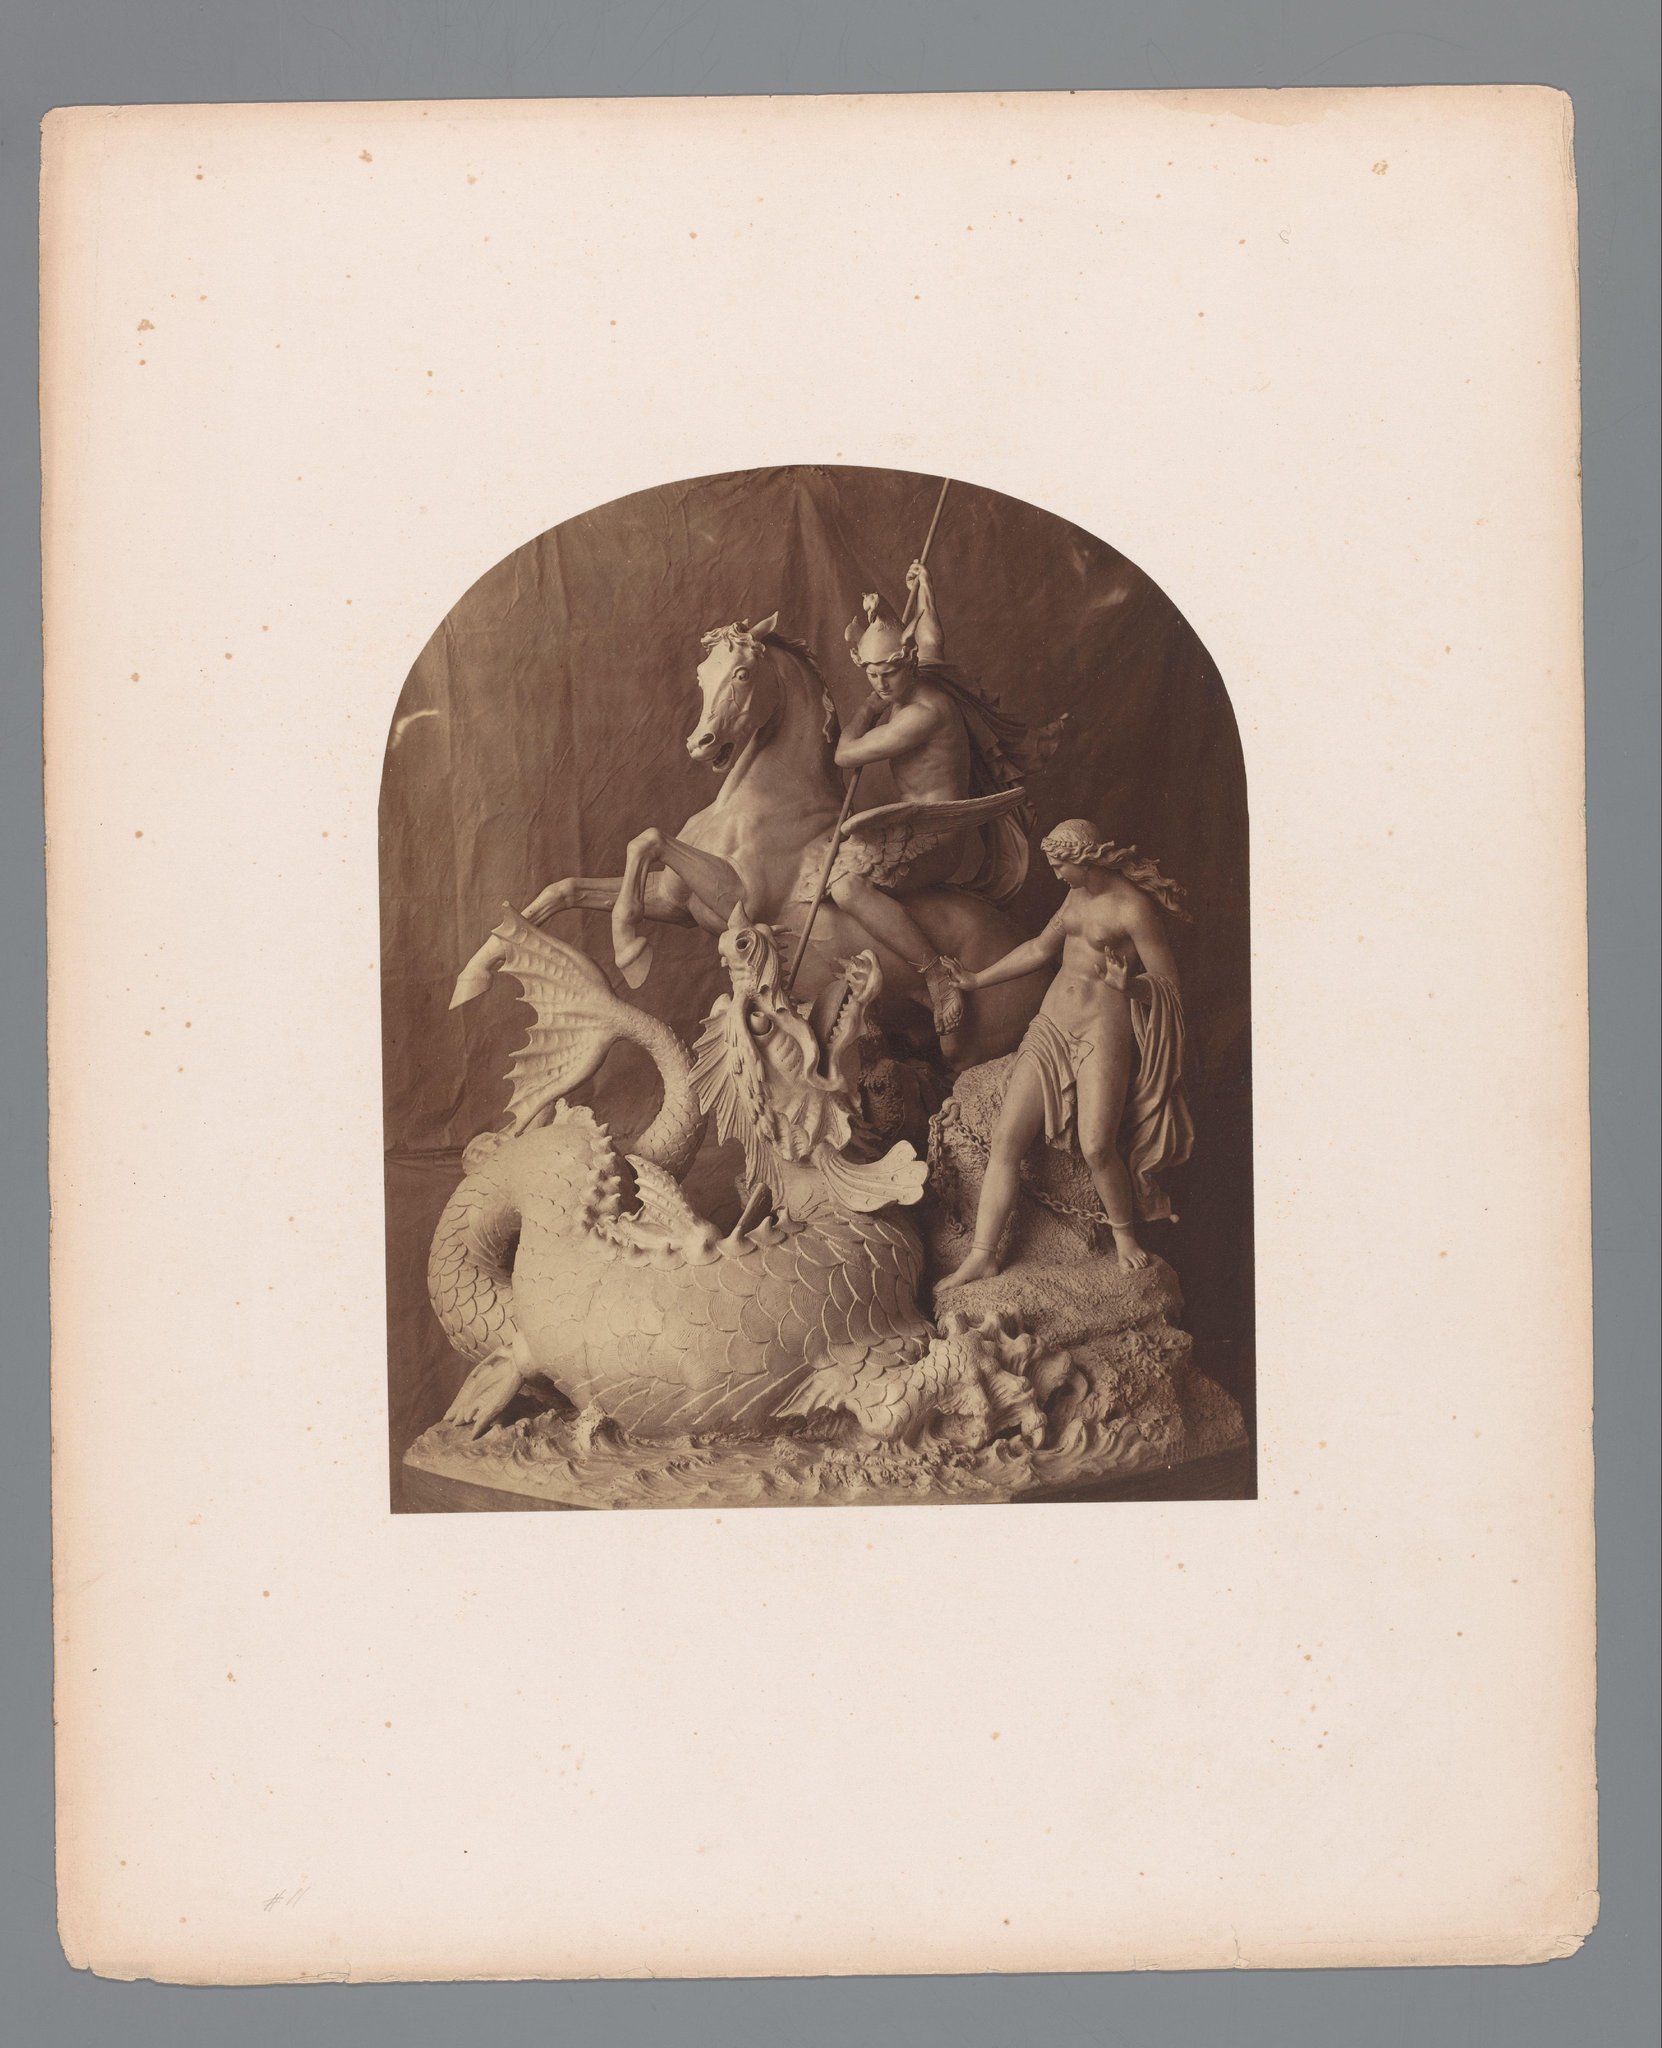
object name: photograph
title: Sculptuur van Perseus en Andromeda door William Andrews Nesfield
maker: charles thurston thompson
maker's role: fotograaf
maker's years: 1816-1868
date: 1853-1858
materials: photographic support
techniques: albumen print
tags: piece of sculpture, reproduction of a piece of sculpture, perseus, riding on pegasus, kills the sea monster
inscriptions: annotation: ‘#11’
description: Deze foto maakt deel uit van een omslag met acht foto's, twee tekstbladen en een dekblad.